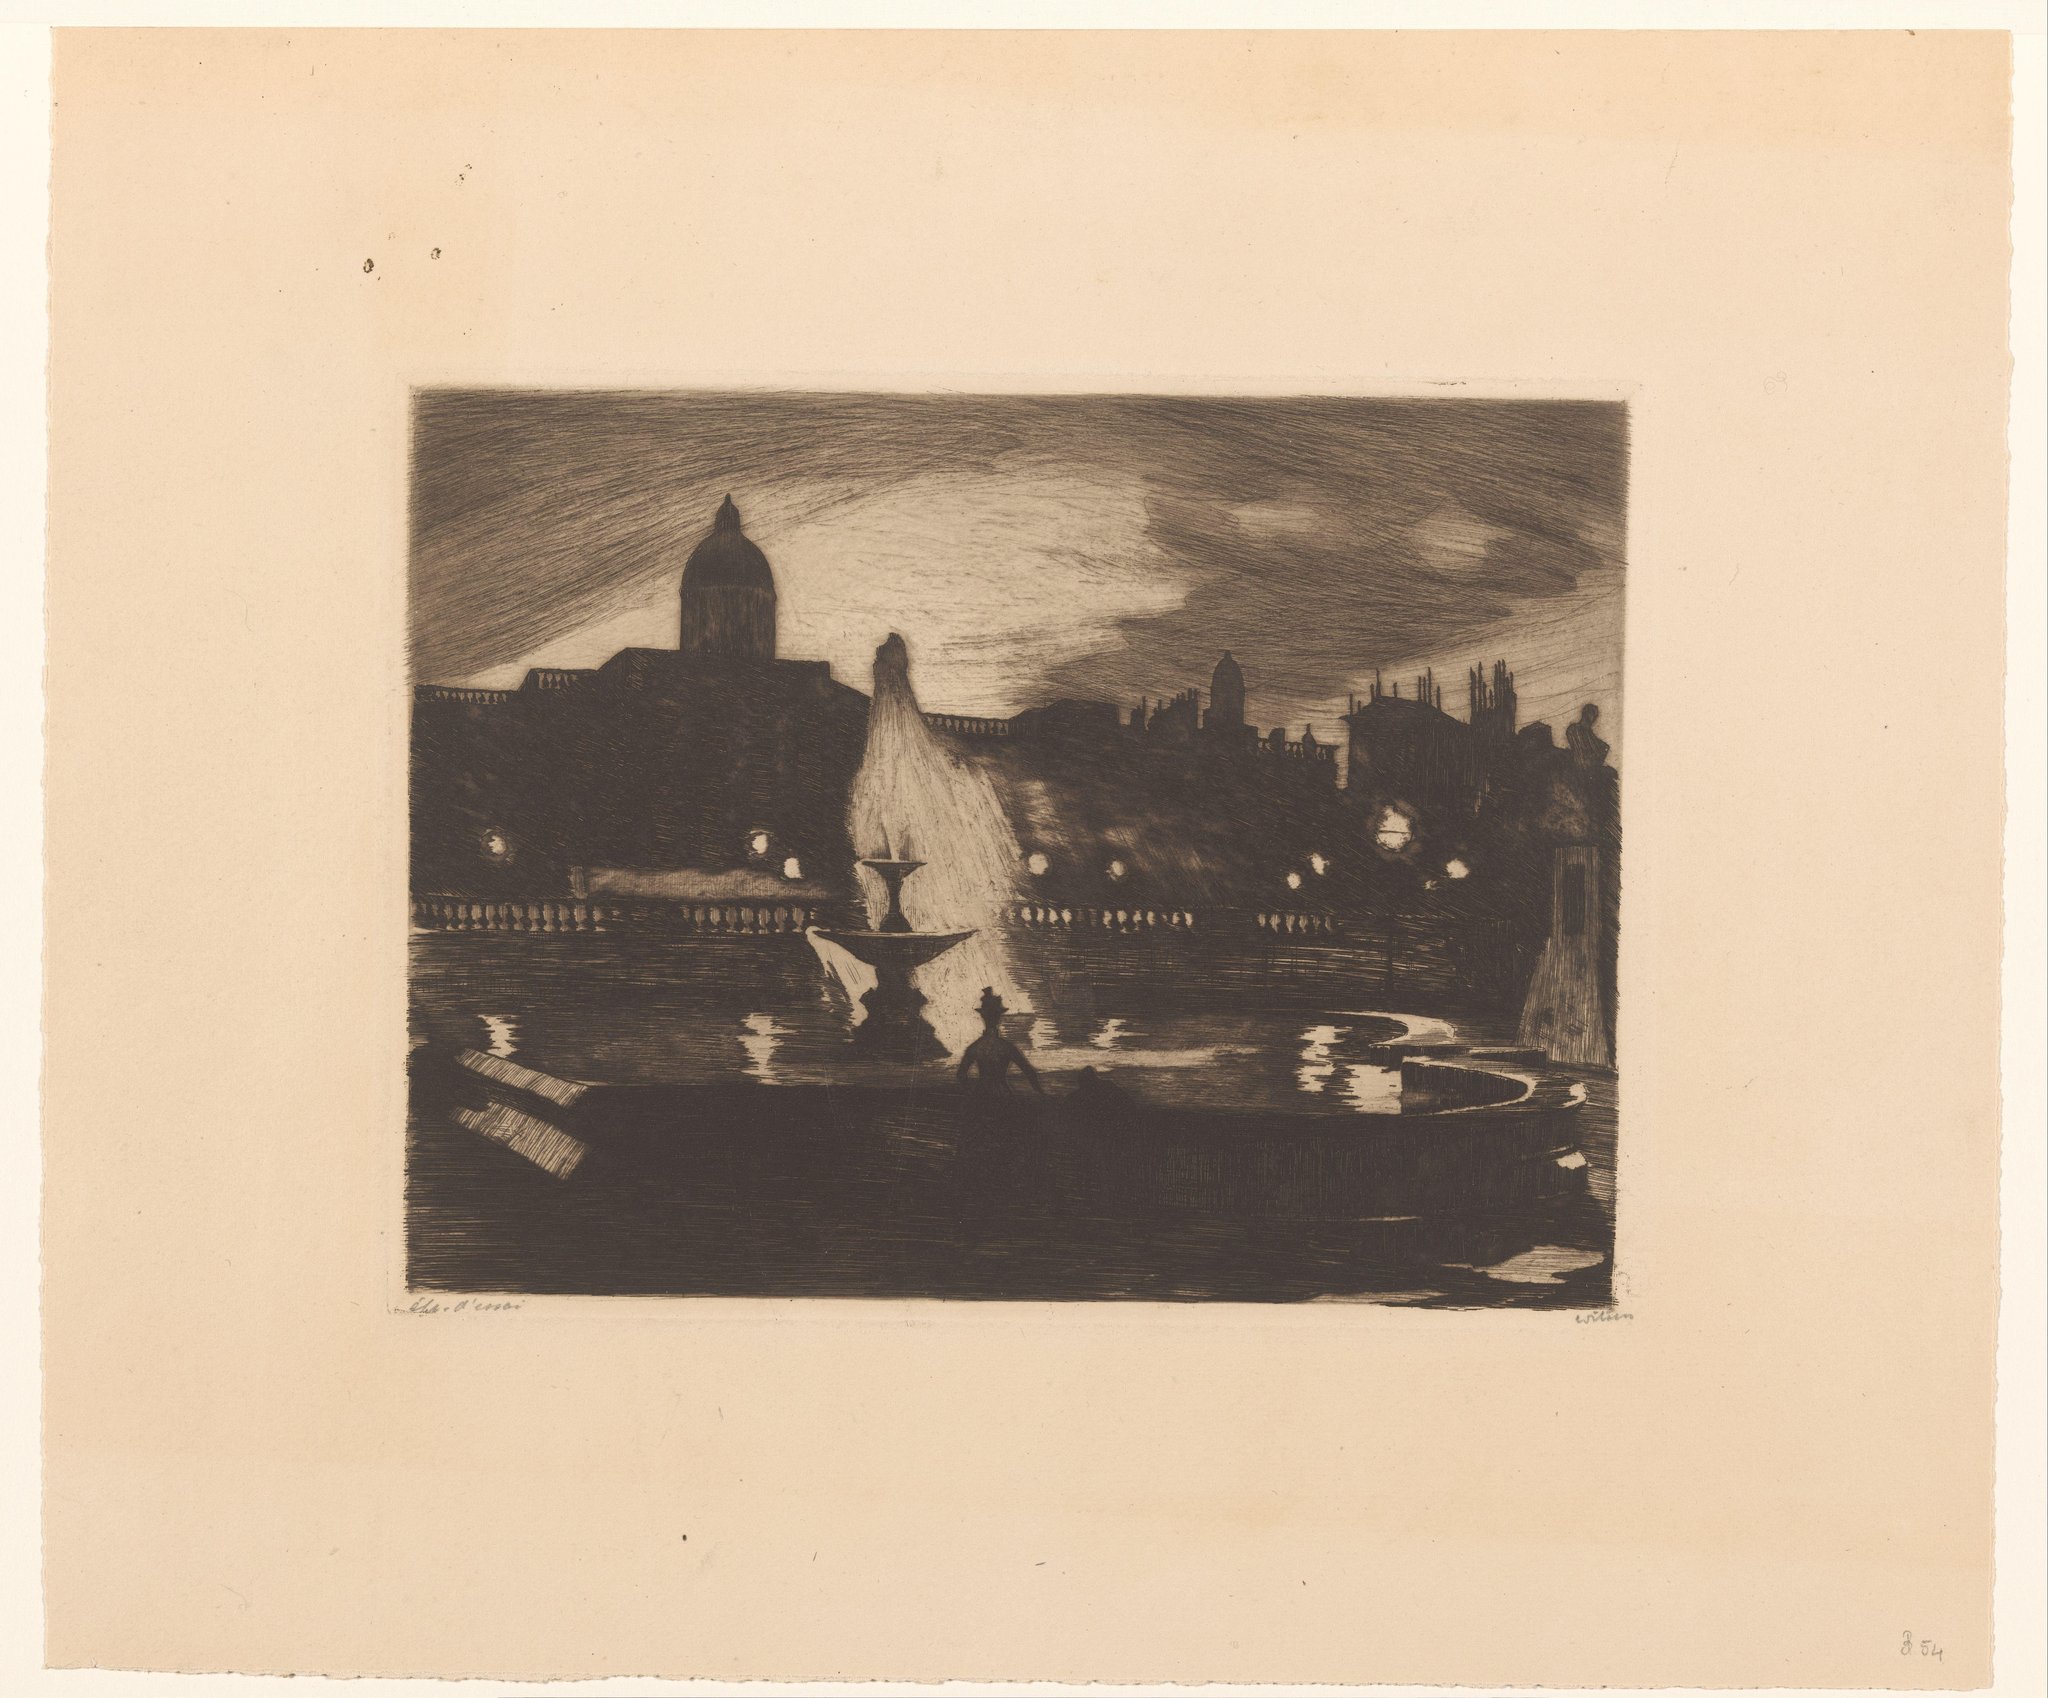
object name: print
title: Gezicht op Trafalgar Square en de National Gallery in Londen bij avond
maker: willem witsen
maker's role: draughtsman, painter, print maker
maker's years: 1860-1923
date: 1890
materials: paper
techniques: etching, intaglio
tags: square, place, circus, etc., city-view in general; 'veduta', ornamental fountain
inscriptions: collector's mark: Lugt 2228, watermark, inscription: ‘epr. d'essai’, signature: ‘Witsen’